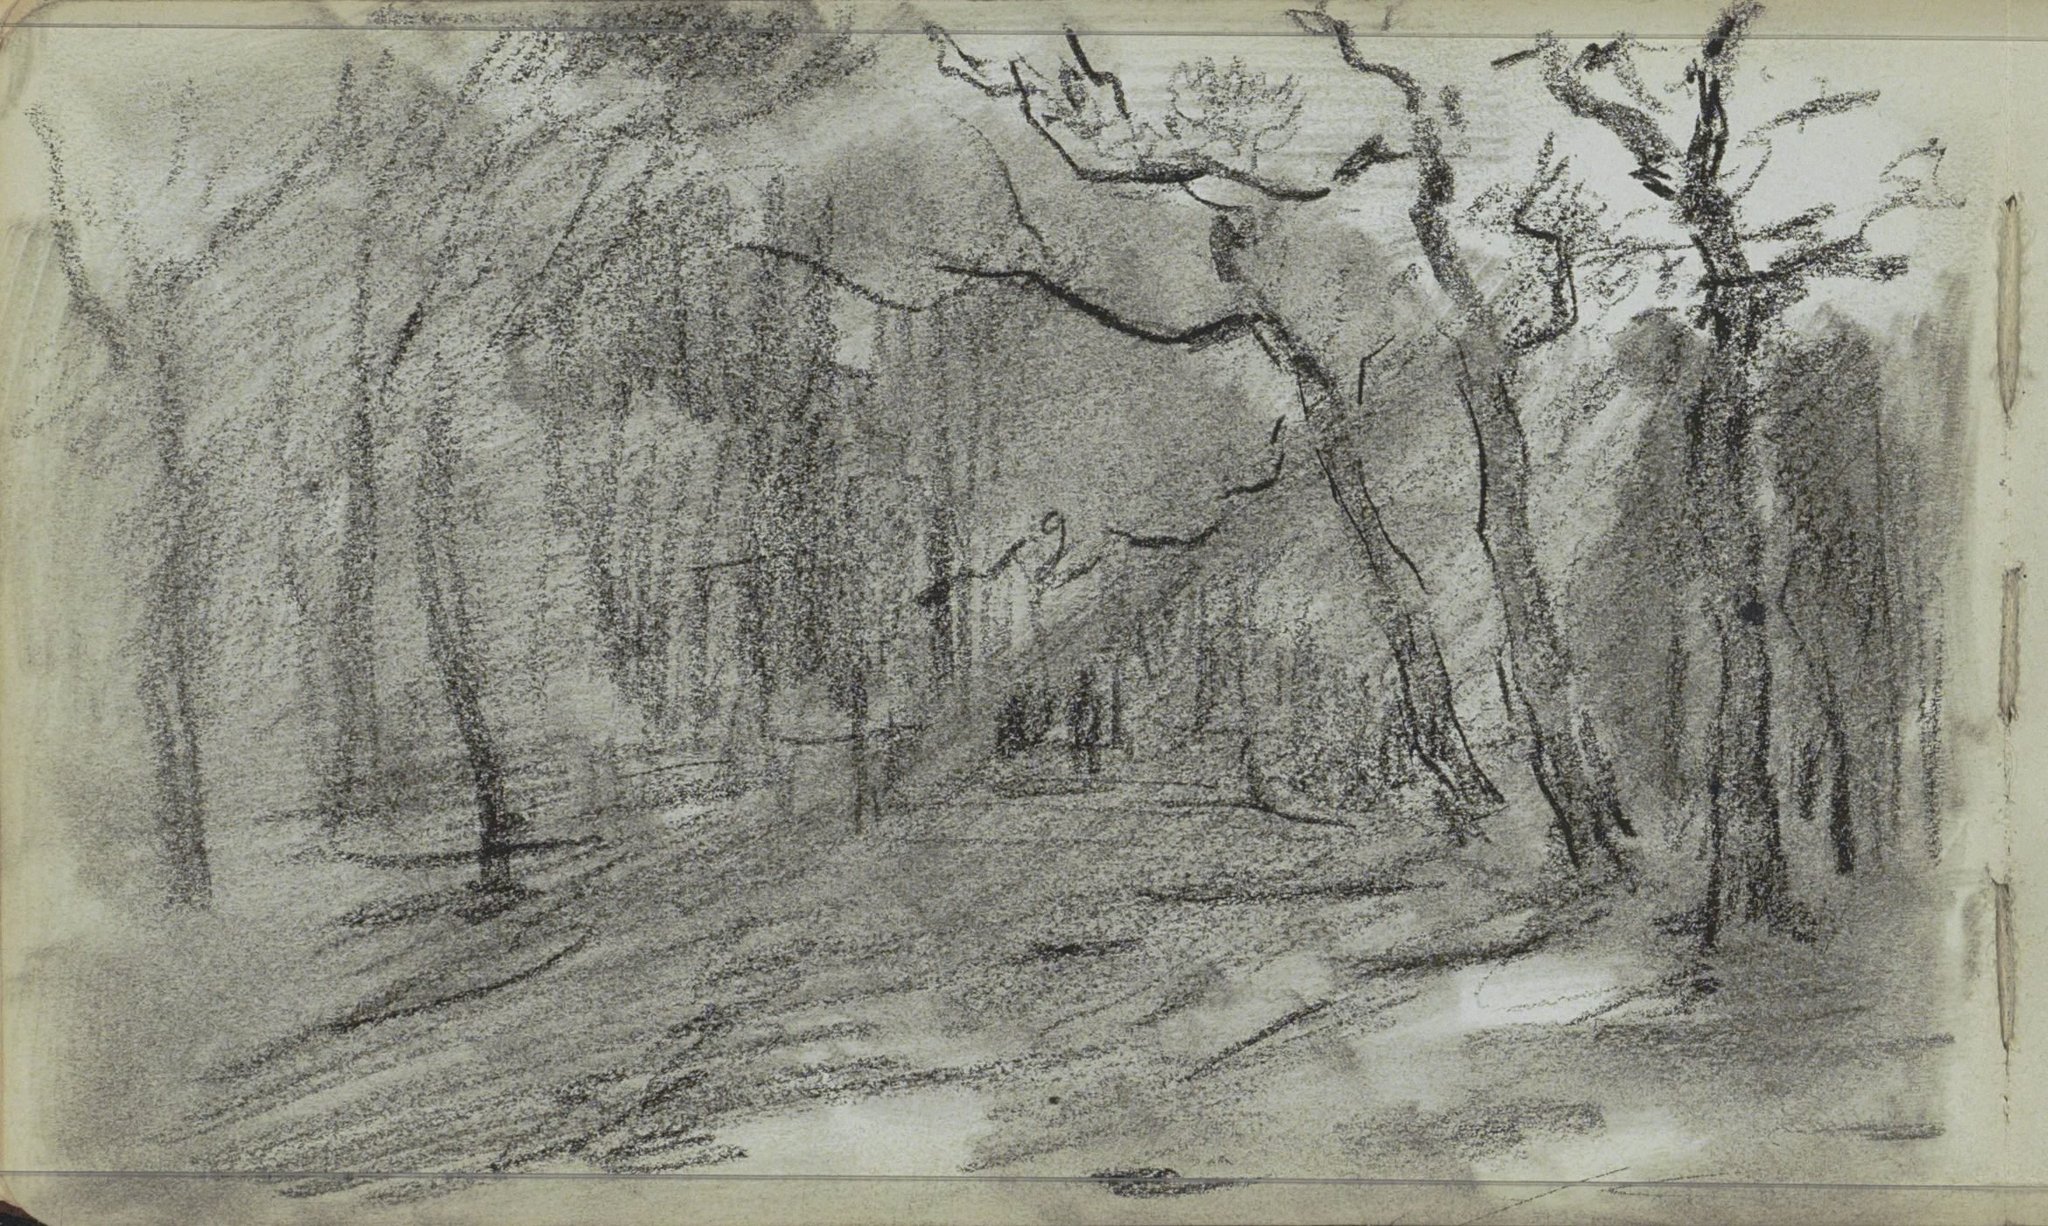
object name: sketchbook leaf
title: Figuren op een bospad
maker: johan antonie de jonge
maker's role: draughtsman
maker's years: 1864-1927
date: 1881-1927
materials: chalk, paper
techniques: stumping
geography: south holland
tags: forest path or lane (+ landscape with figures, staffage)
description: Figuren op een bospad. Blad 15 verso uit een schetsboek met 34 bladen.